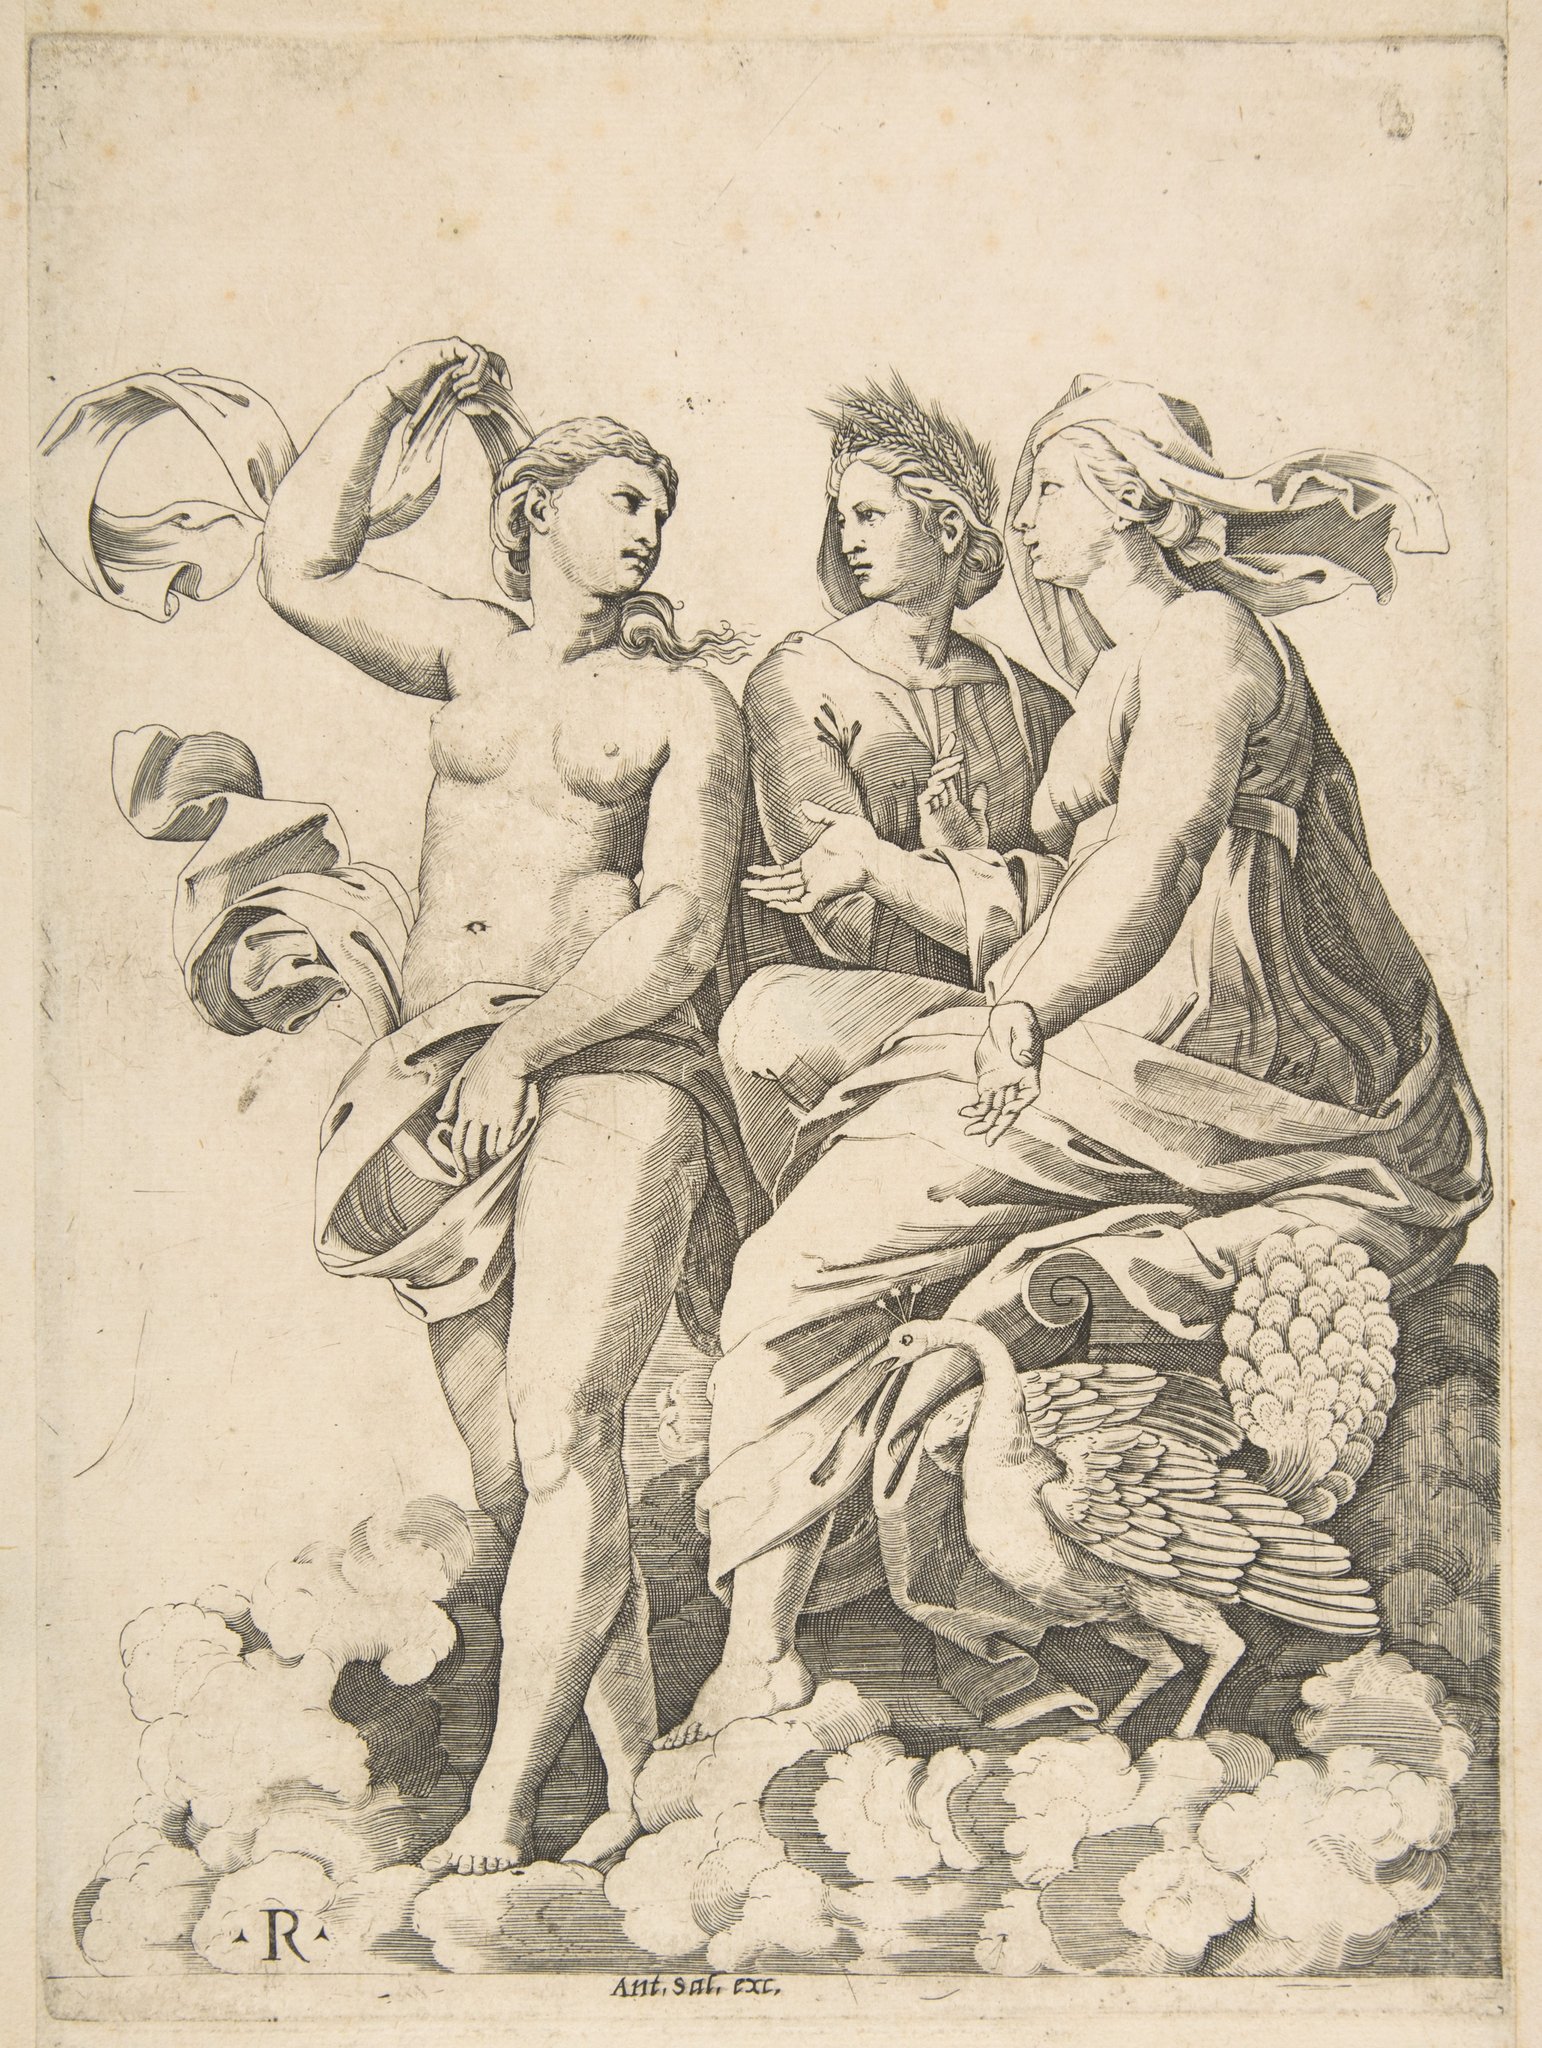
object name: print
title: Juno, Ceres, and Psyche in the clouds conversing, Juno seated with a peacock at her feet, Ceres wearing a garland of wheat and Psyche partially naked and holding a cloth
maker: marco dente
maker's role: artist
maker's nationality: italian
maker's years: 1515-1527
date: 1515-1527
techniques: engraving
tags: female nudes,psyche,ceres,juno,peacocks